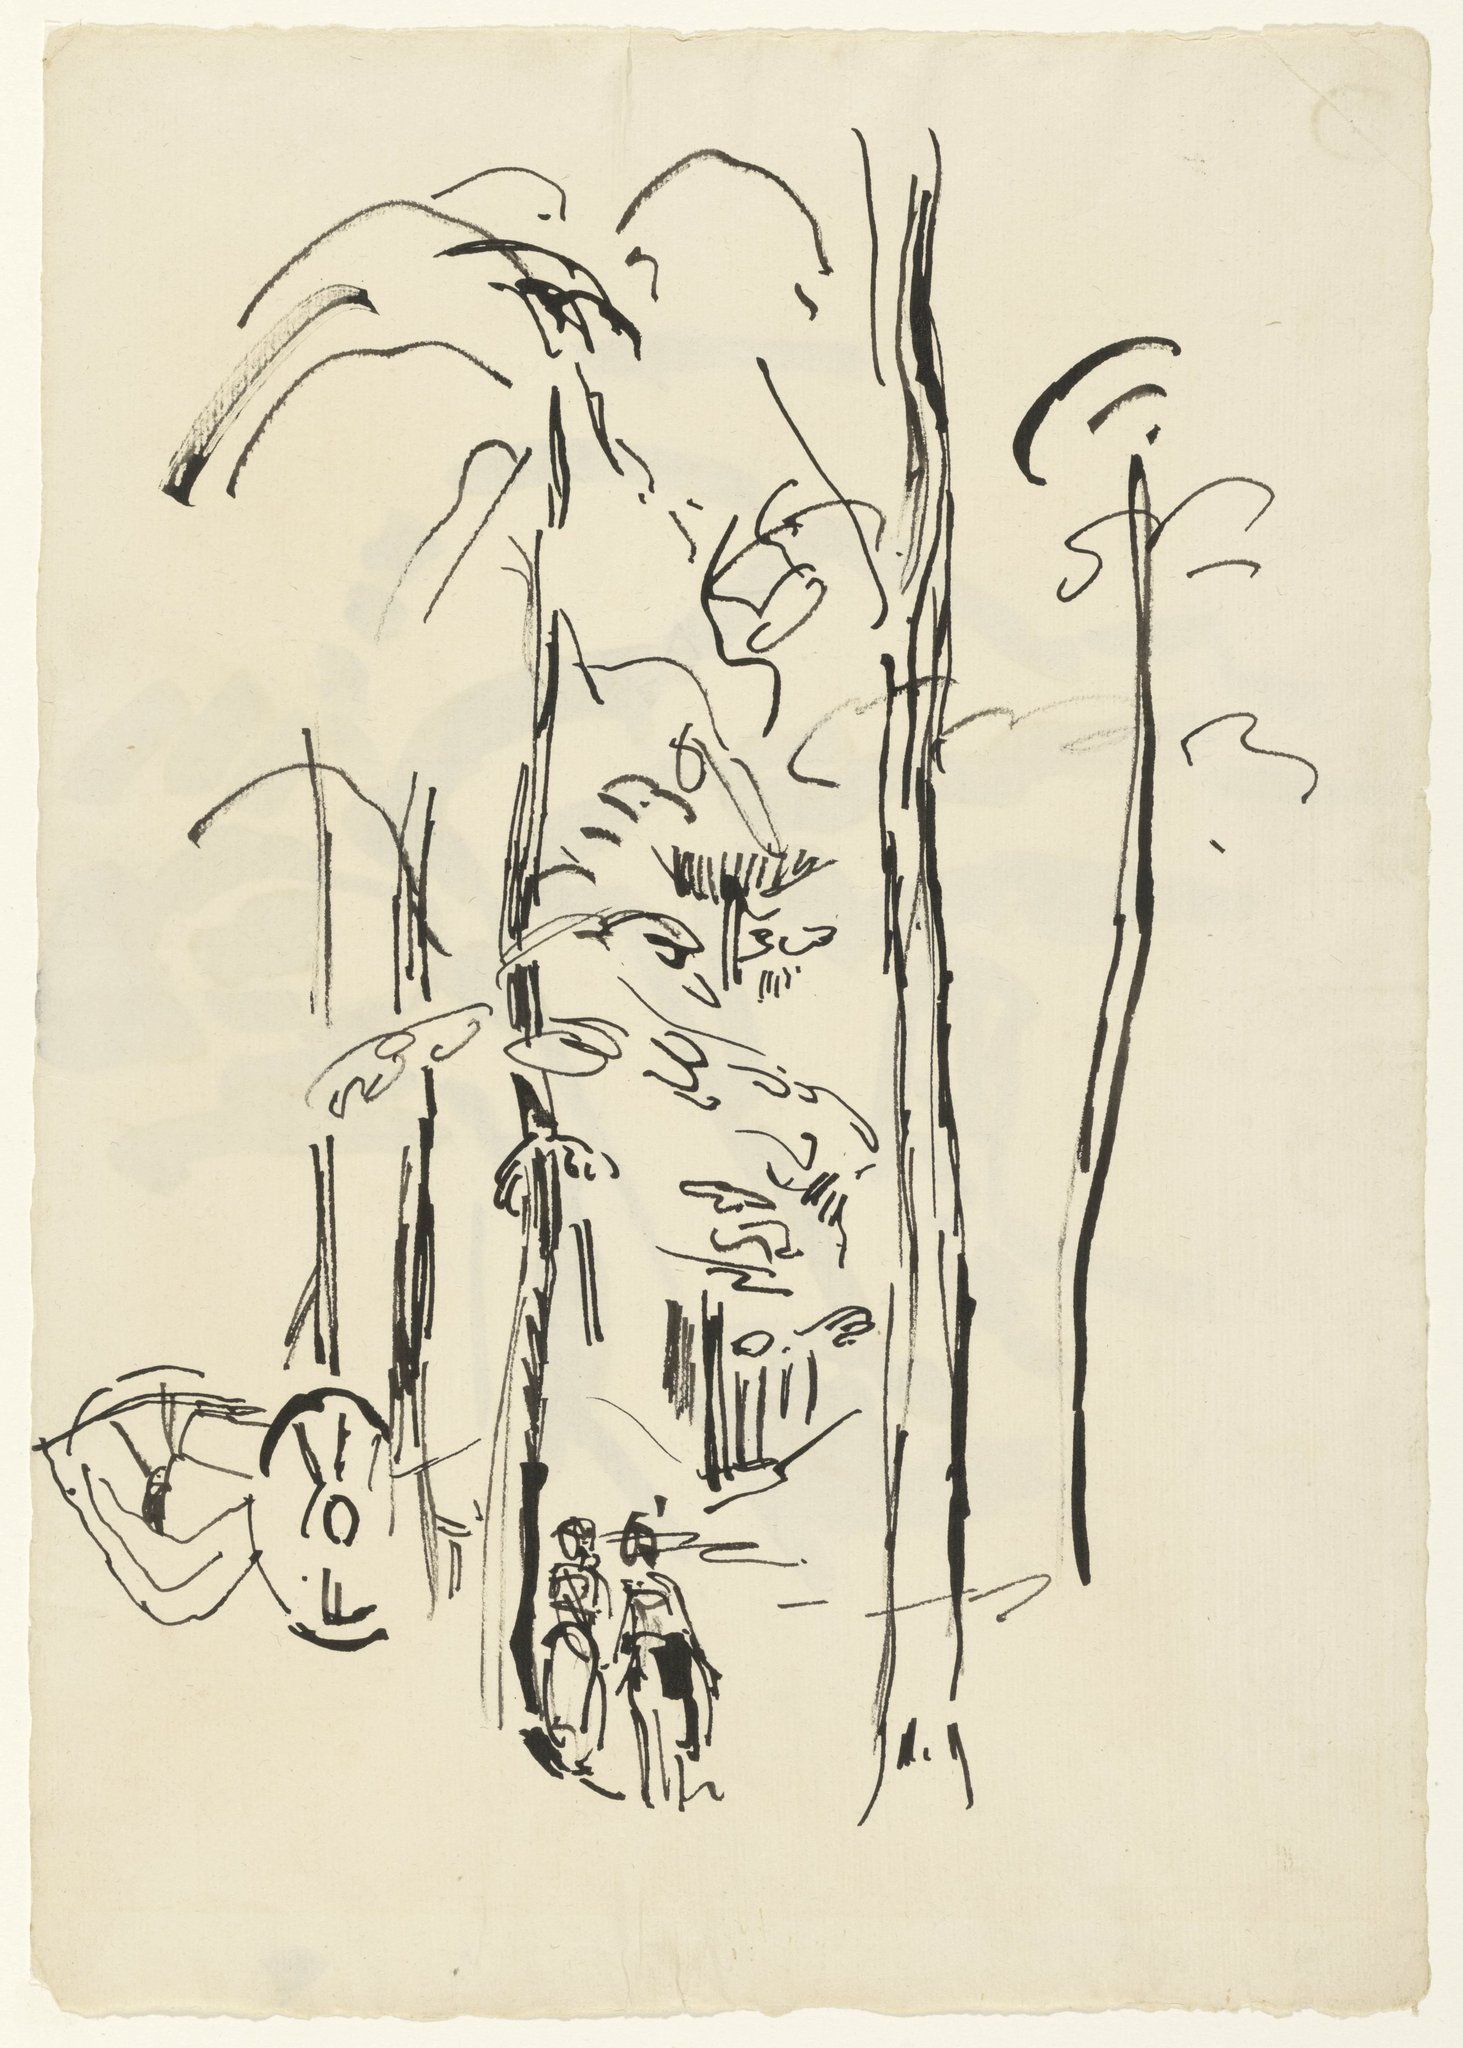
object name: drawing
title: Dennenbos, met twee wandelende dames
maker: rik wouters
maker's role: draughtsman, print maker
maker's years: 1882-1916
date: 1892-1916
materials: ink, paper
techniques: pen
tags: forest, wood